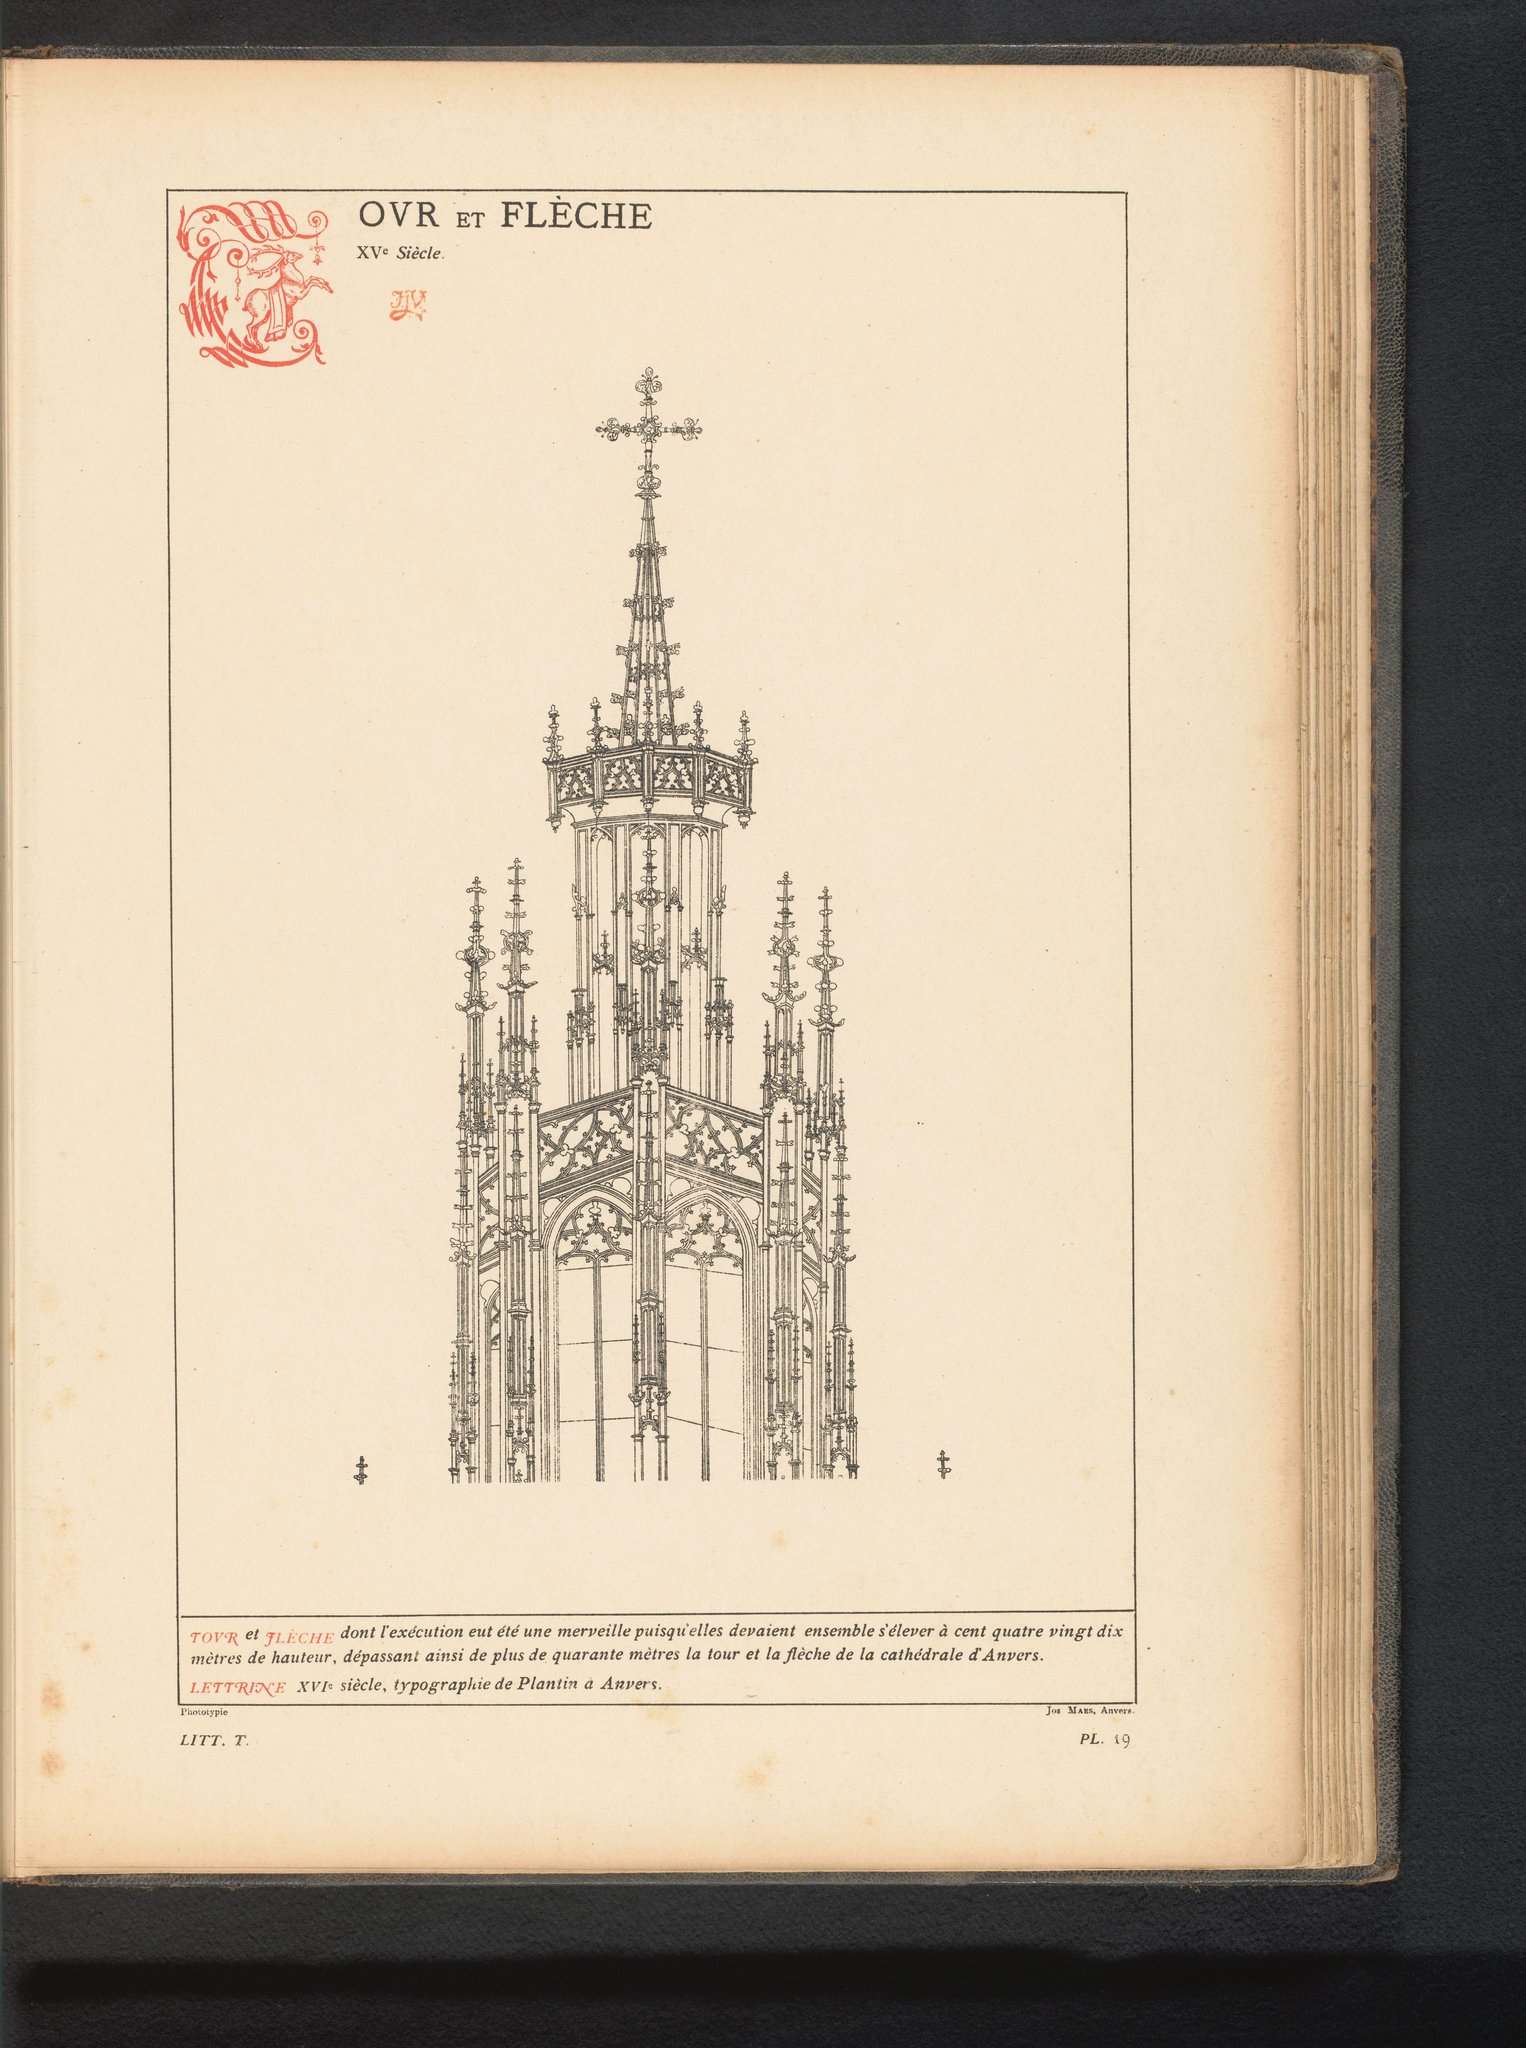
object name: page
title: Tour et flèche, XVe Siècle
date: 1876-1881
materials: paper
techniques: photolithography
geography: antwerp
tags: church (exterior)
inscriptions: monogram: ‘JJvY’, inscription: ‘TOUR et FLÈCHE (...)’, inscription: ‘LITT. T. - PL. 19.’